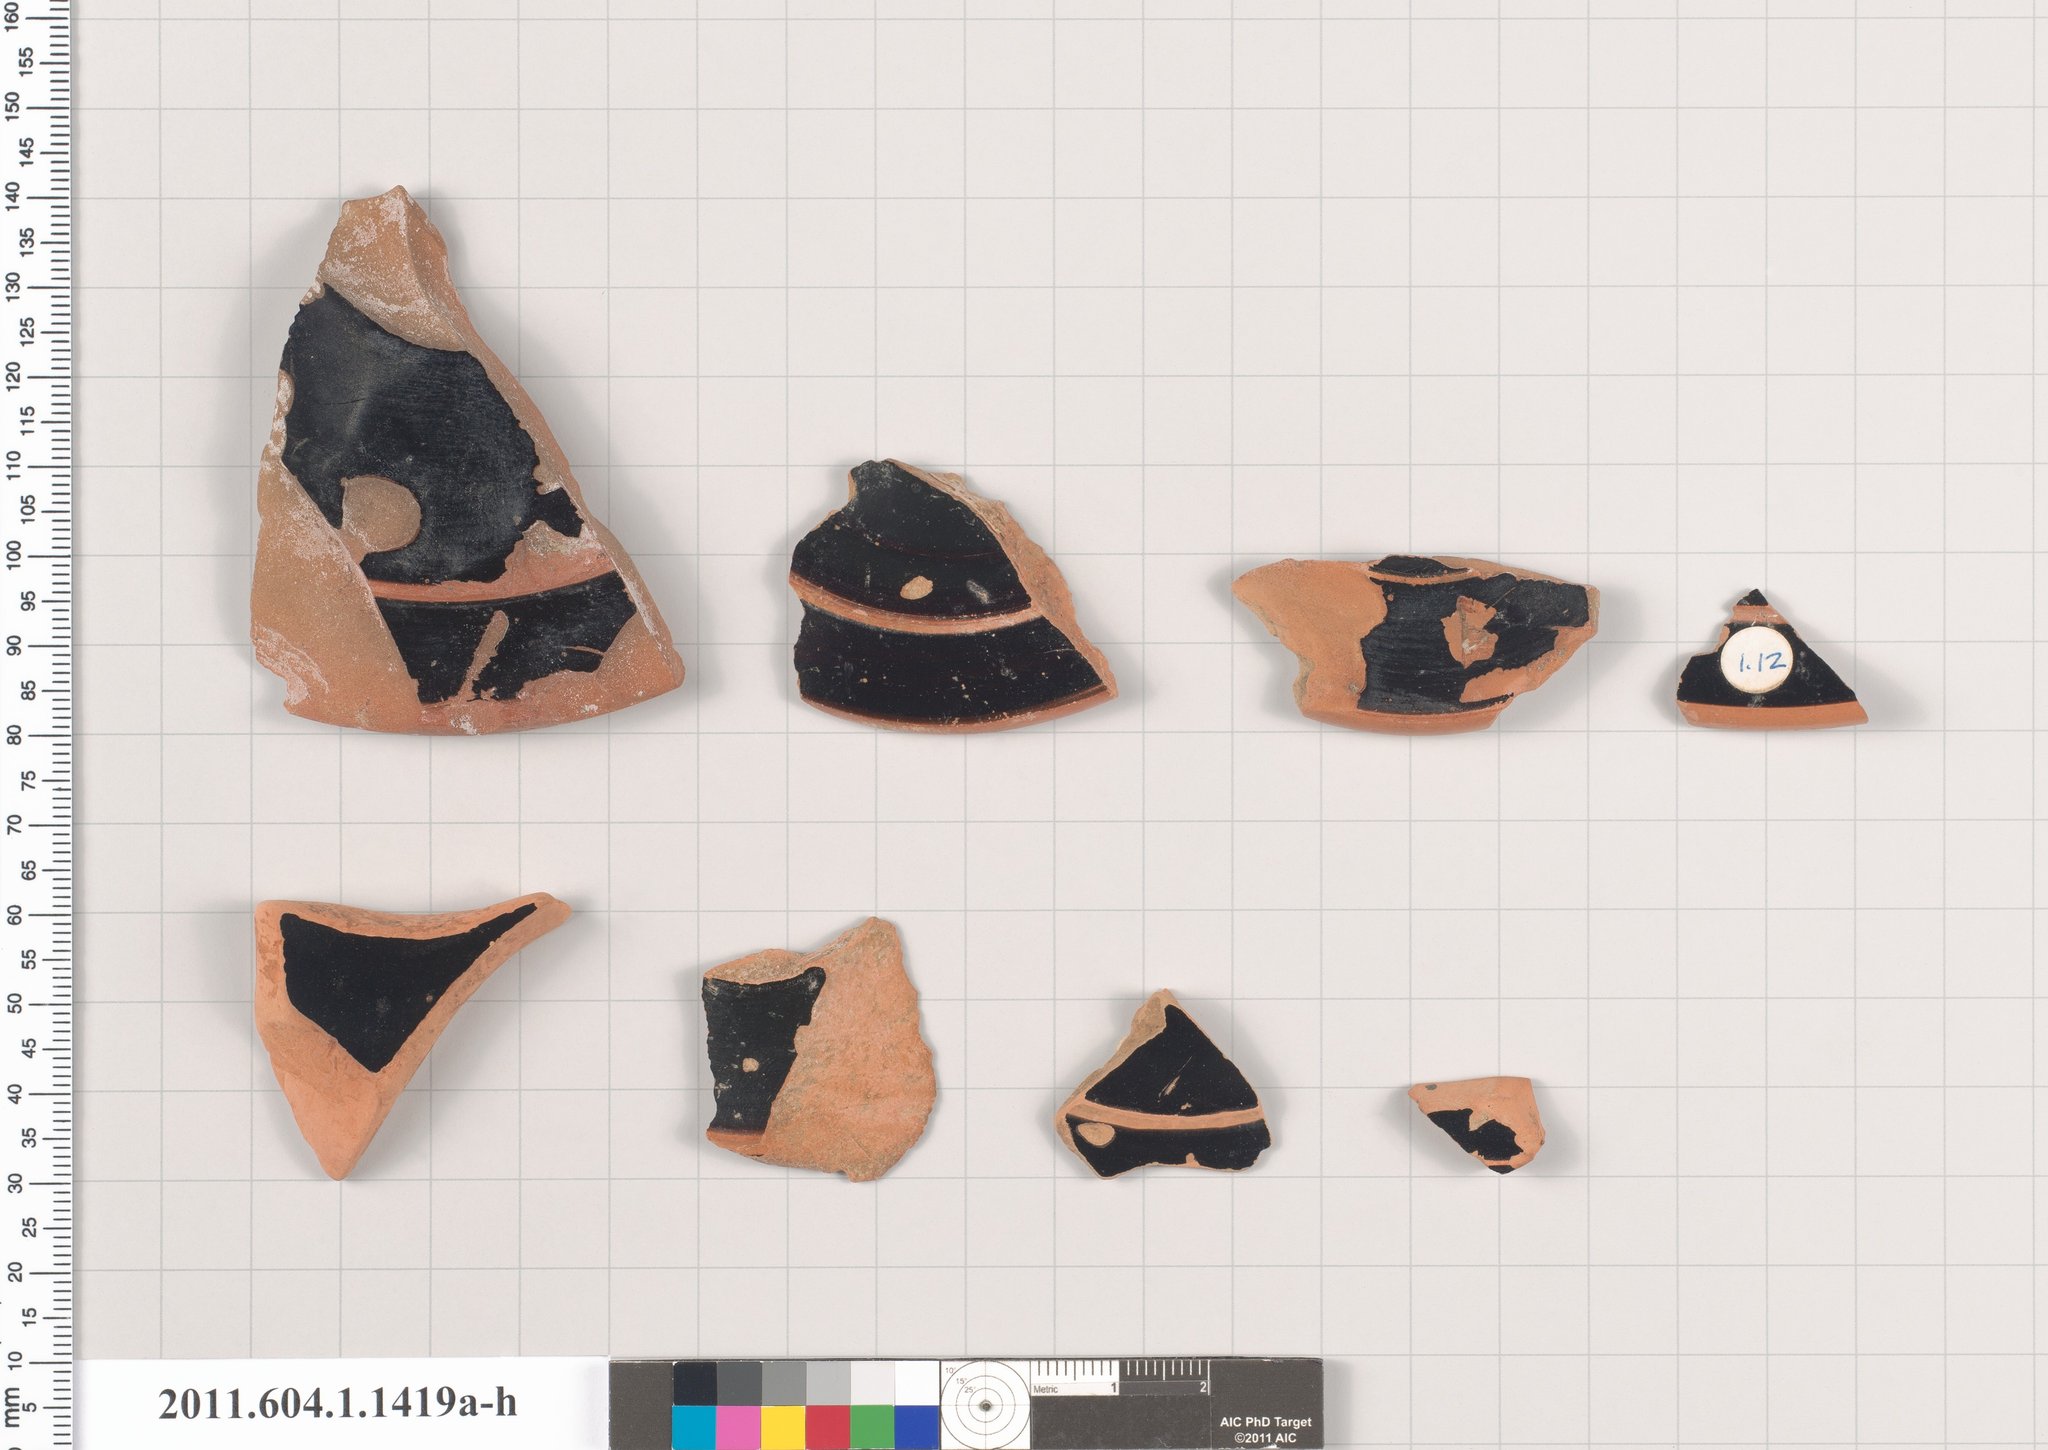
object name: kylix fragment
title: Terracotta fragments of kylikes (drinking cups)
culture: greek, attic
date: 500-401 BCE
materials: terracotta